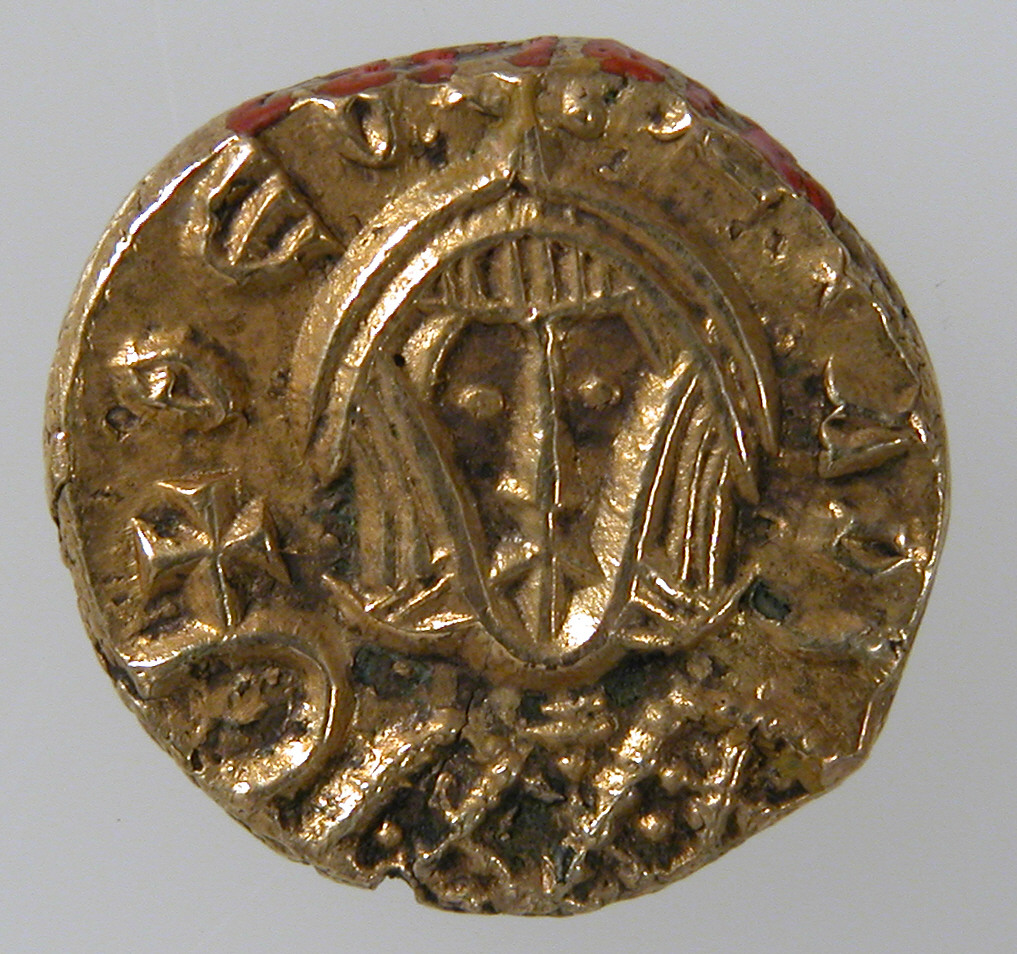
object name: coin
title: Gold Tremissis of Theophilos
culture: byzantine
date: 831-842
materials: gold